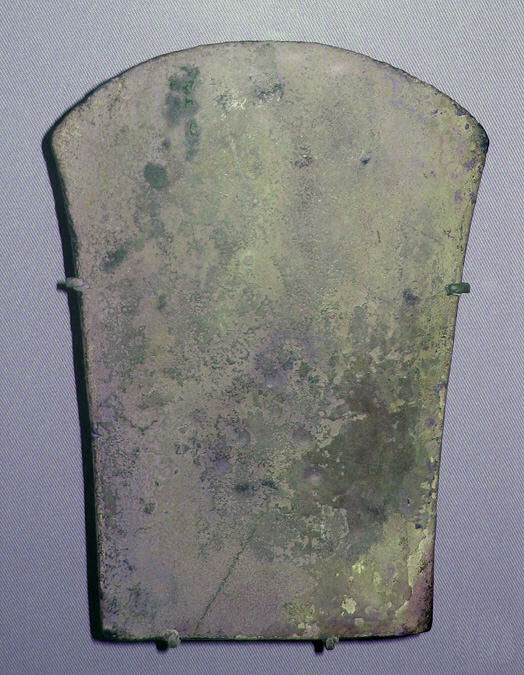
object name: ax blade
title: Ax Blade (Celt)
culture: indian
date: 1500-500 BCE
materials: copper